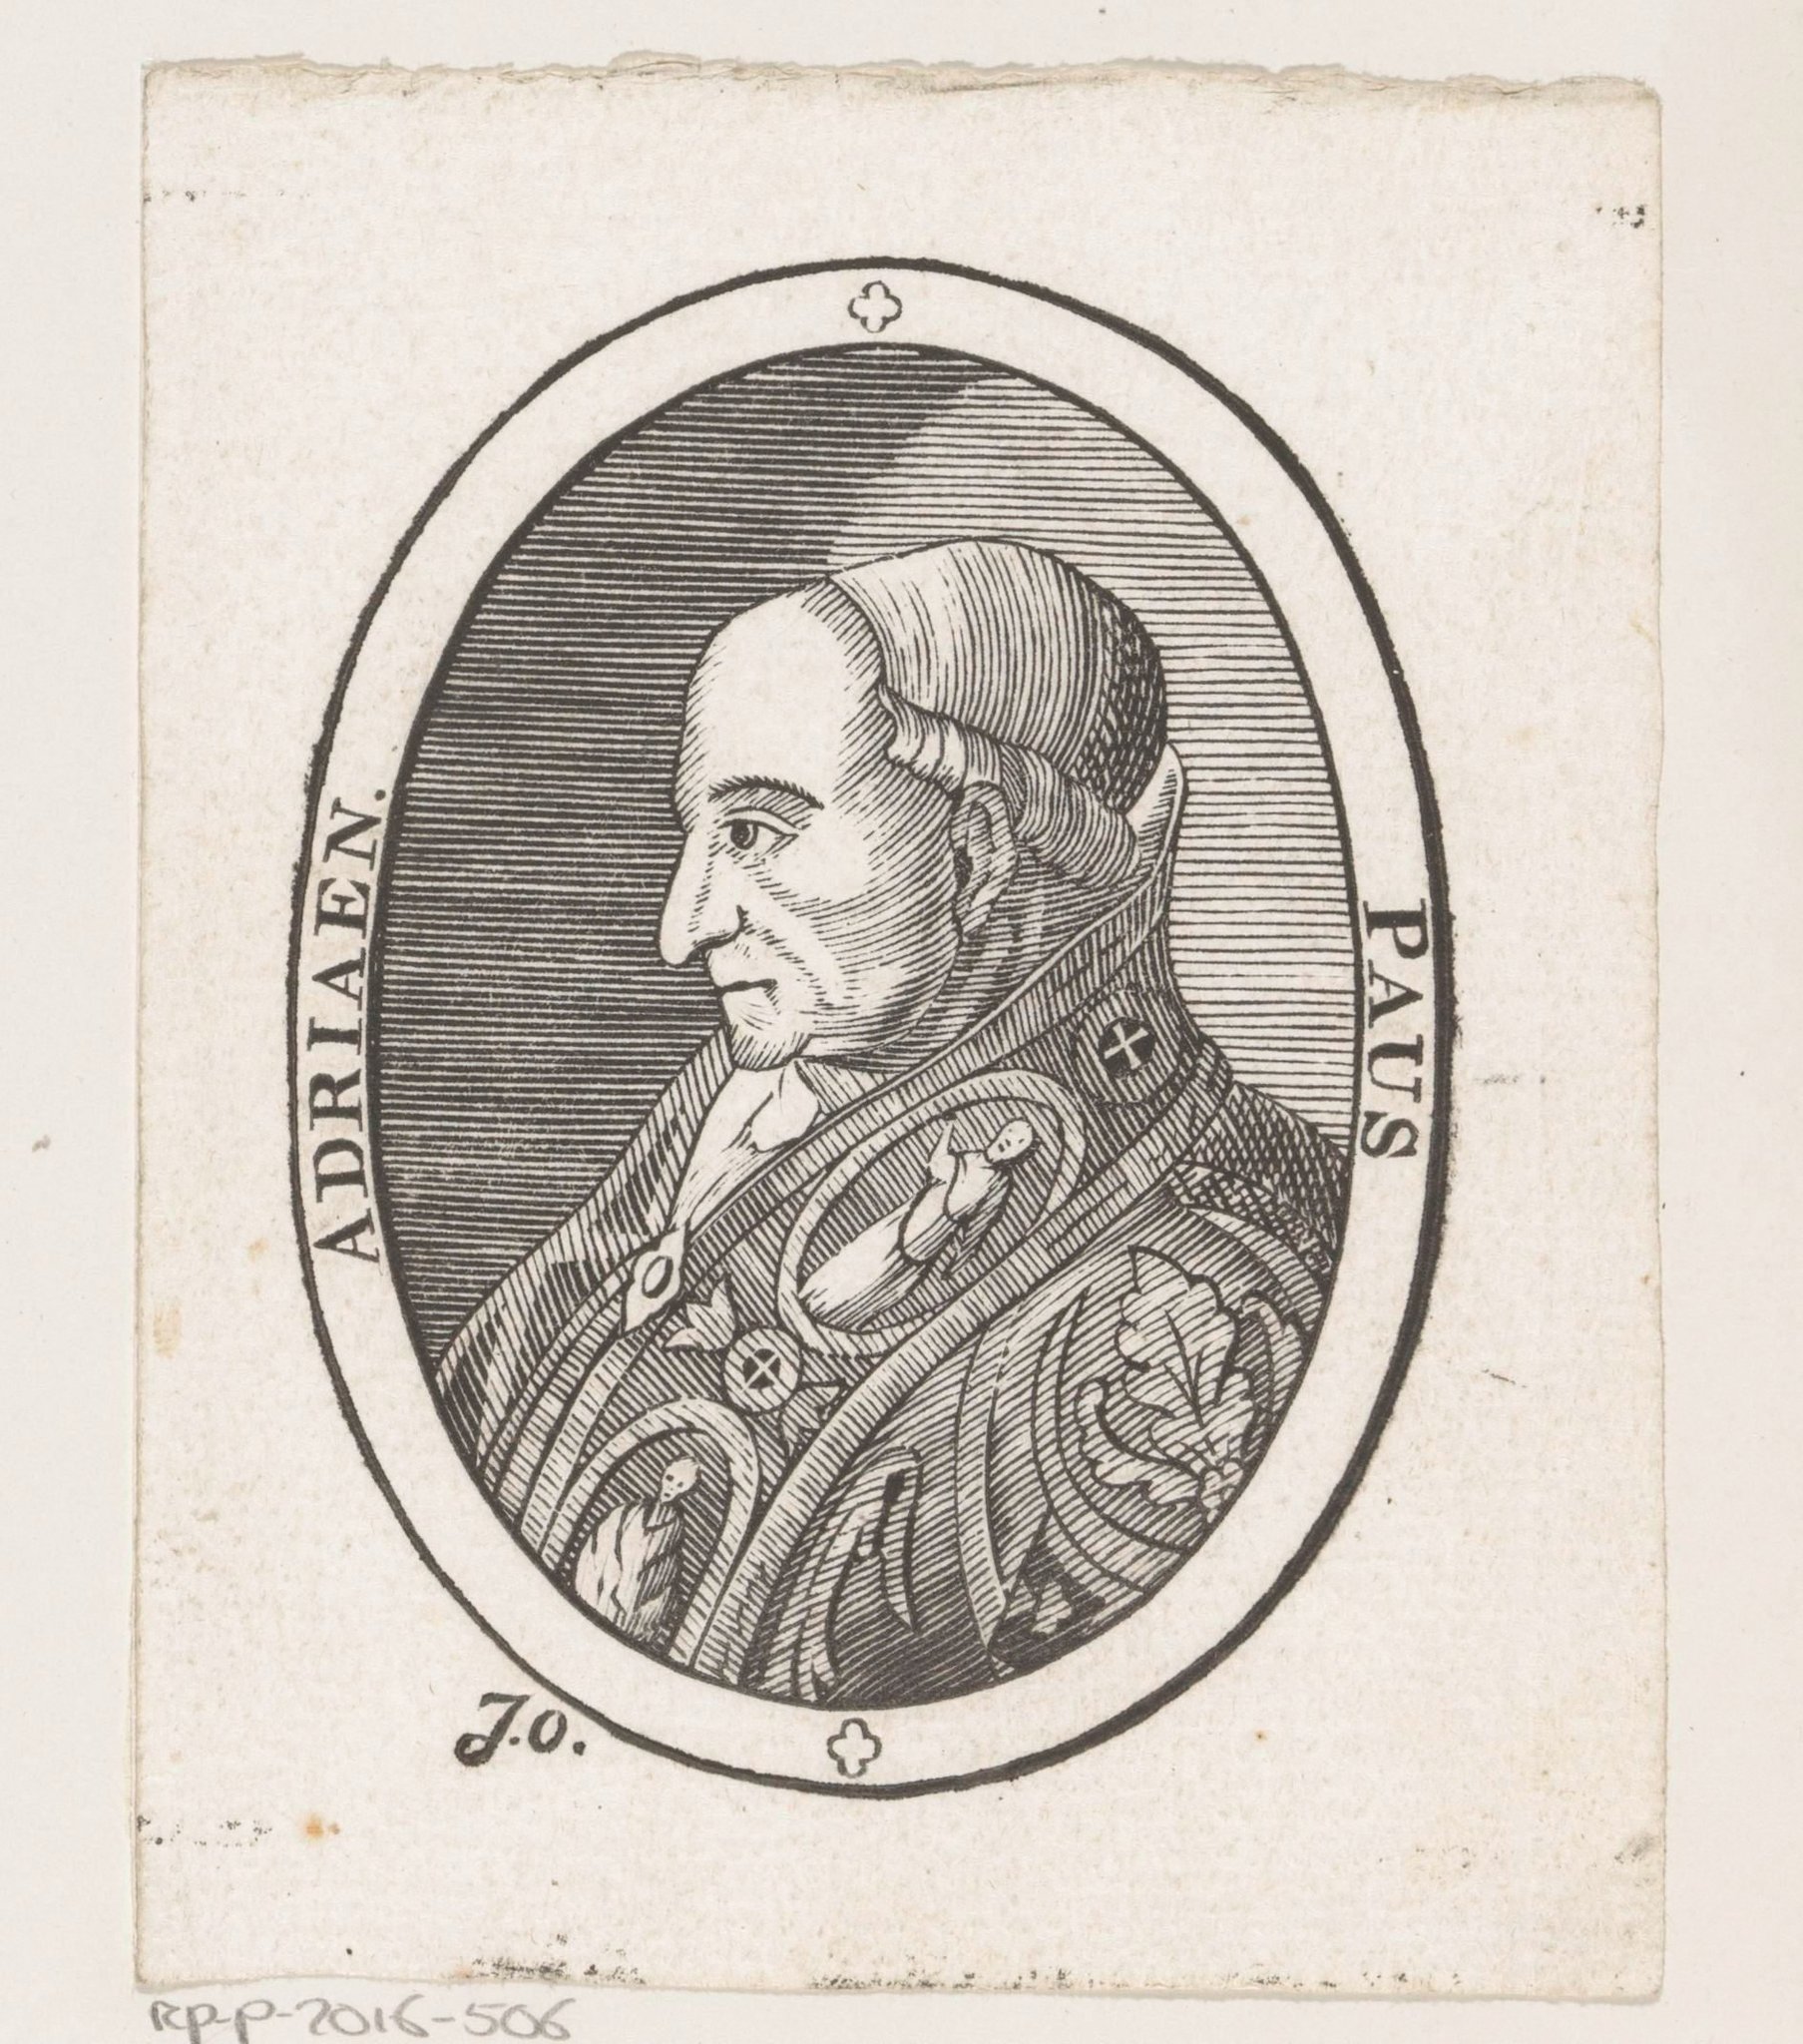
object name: print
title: Portret van paus Adrianus VI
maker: Anonymous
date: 1700-1799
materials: paper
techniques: engraving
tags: utrecht, rome, clergyman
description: Portret van paus Adrianus VI in een ovale omlijsting met randschrift.